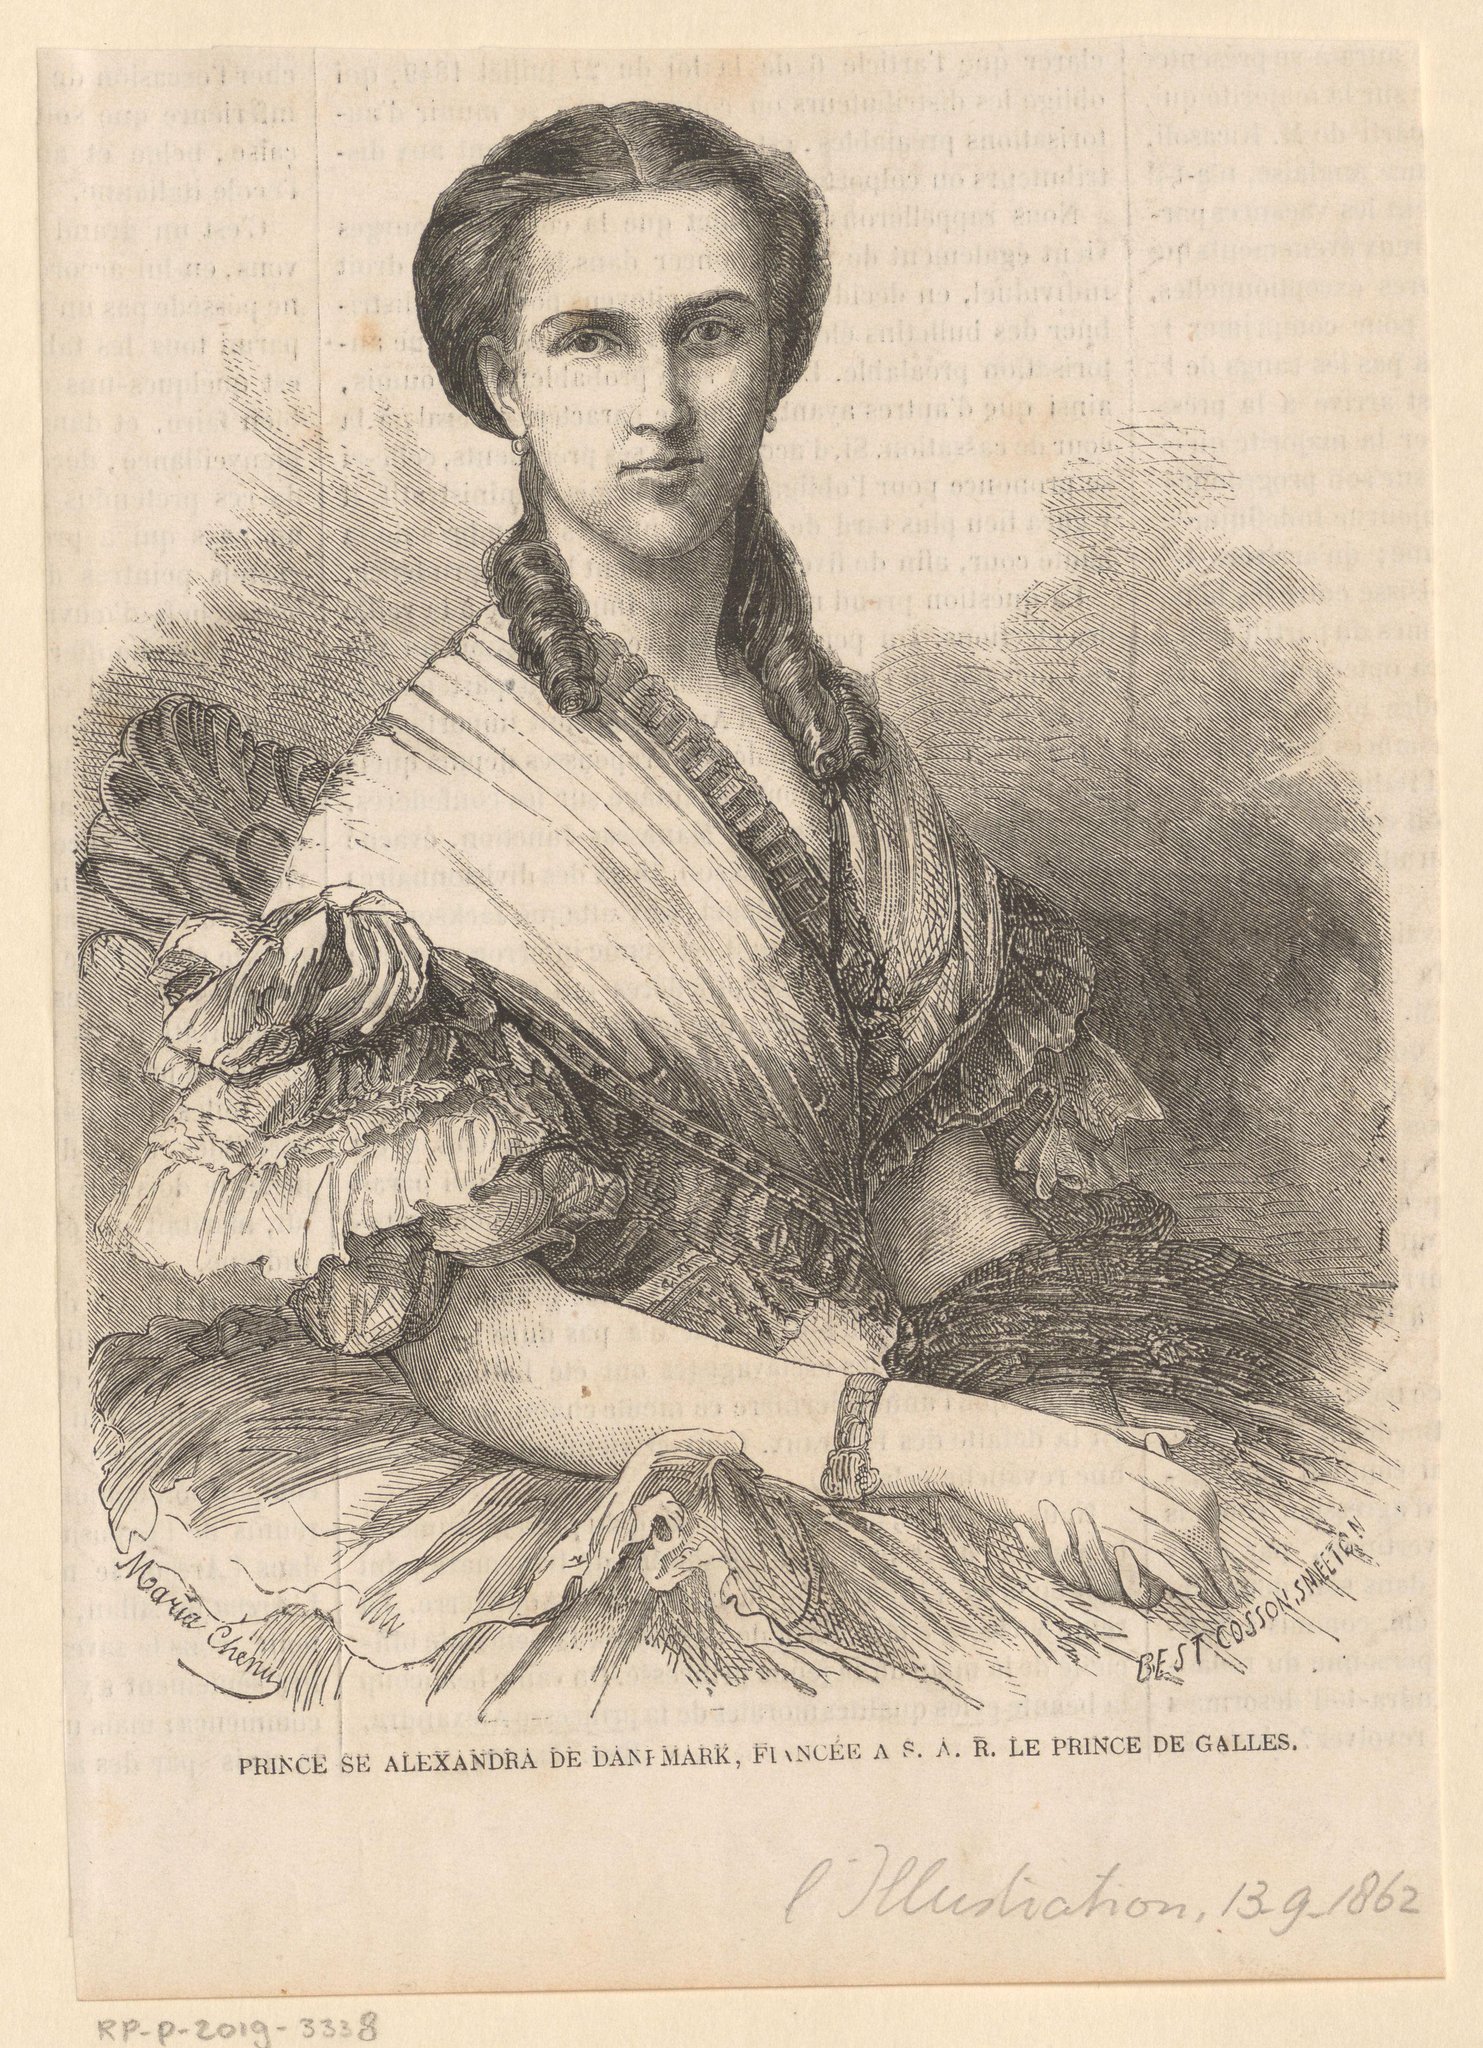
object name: print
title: Portret van Alexandra van Denemarken, koningin van England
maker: marguerite-marie chenu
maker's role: draughtsman, print maker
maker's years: 1829-1905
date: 1862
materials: paper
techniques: letterpress printing, engraving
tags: copenhagen (city), historical persons - bb - woman, ruler, sovereign - bb - female ruler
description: Prent uit: L'illustration, journal universelle, nr. 1020, 13 september 1962.